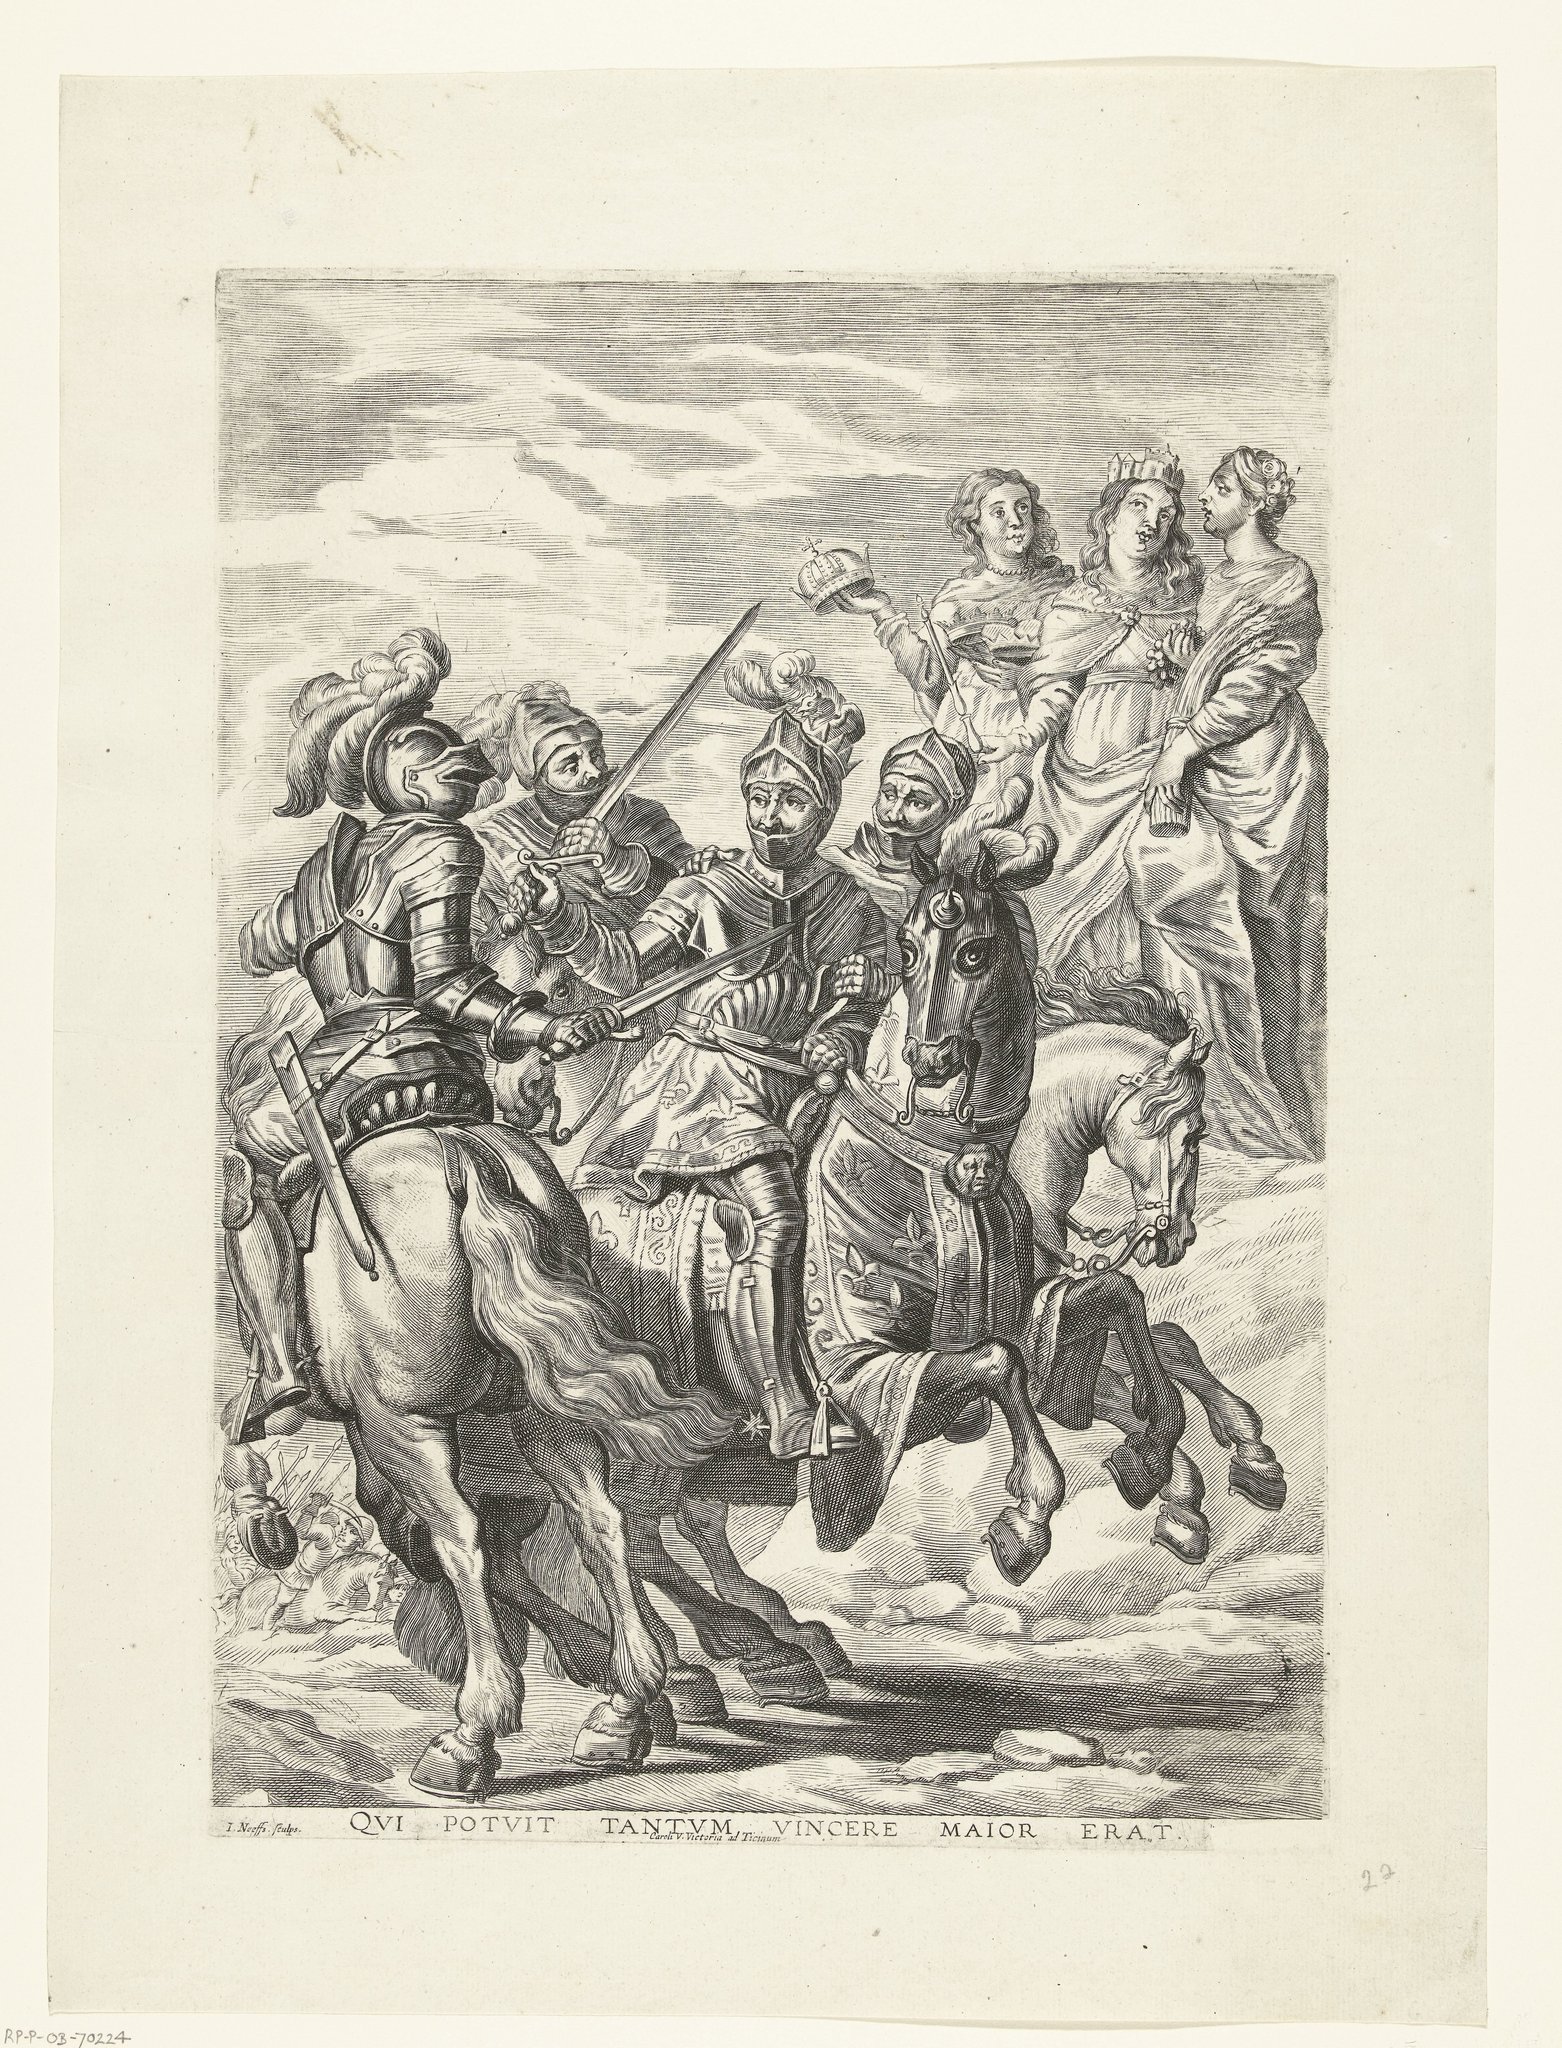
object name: history print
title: Tabula III. Caroli victoria ad Ticinum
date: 1635-1636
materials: paper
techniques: engraving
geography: southern netherlands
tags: frans i van valois-angoulême (koning van frankrijk), ghent, charles v (holy roman emperor and king of spain), brussels, landvoogd der zuidelijke nederlanden ferdinand van oostenrijk, triumphal arch, battle (+ land forces)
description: Overwinning van Karel V op de Fransen tijdens de Slag bij Pavia (Ticinum) en de gevangenneming van de Franse koning Frans I, 24 februari 1525. Ruitergevecht, op de achtergrond kijken drie allegorische vrouwenfiguren toe. Voorstelling links op de voorzijde van de triomfpoort Arcus Caroli op de Vrijdagmarkt. Blad nr. 22 in een geheel van 42 platen die de uitgave van de beschrijving van de intocht van de Kardinaal Infant Ferdinand van Oostenrijk te Gent op 28 januari 1635 als de nieuwe landvoogd voor de Spaanse Nederlanden illustreren.